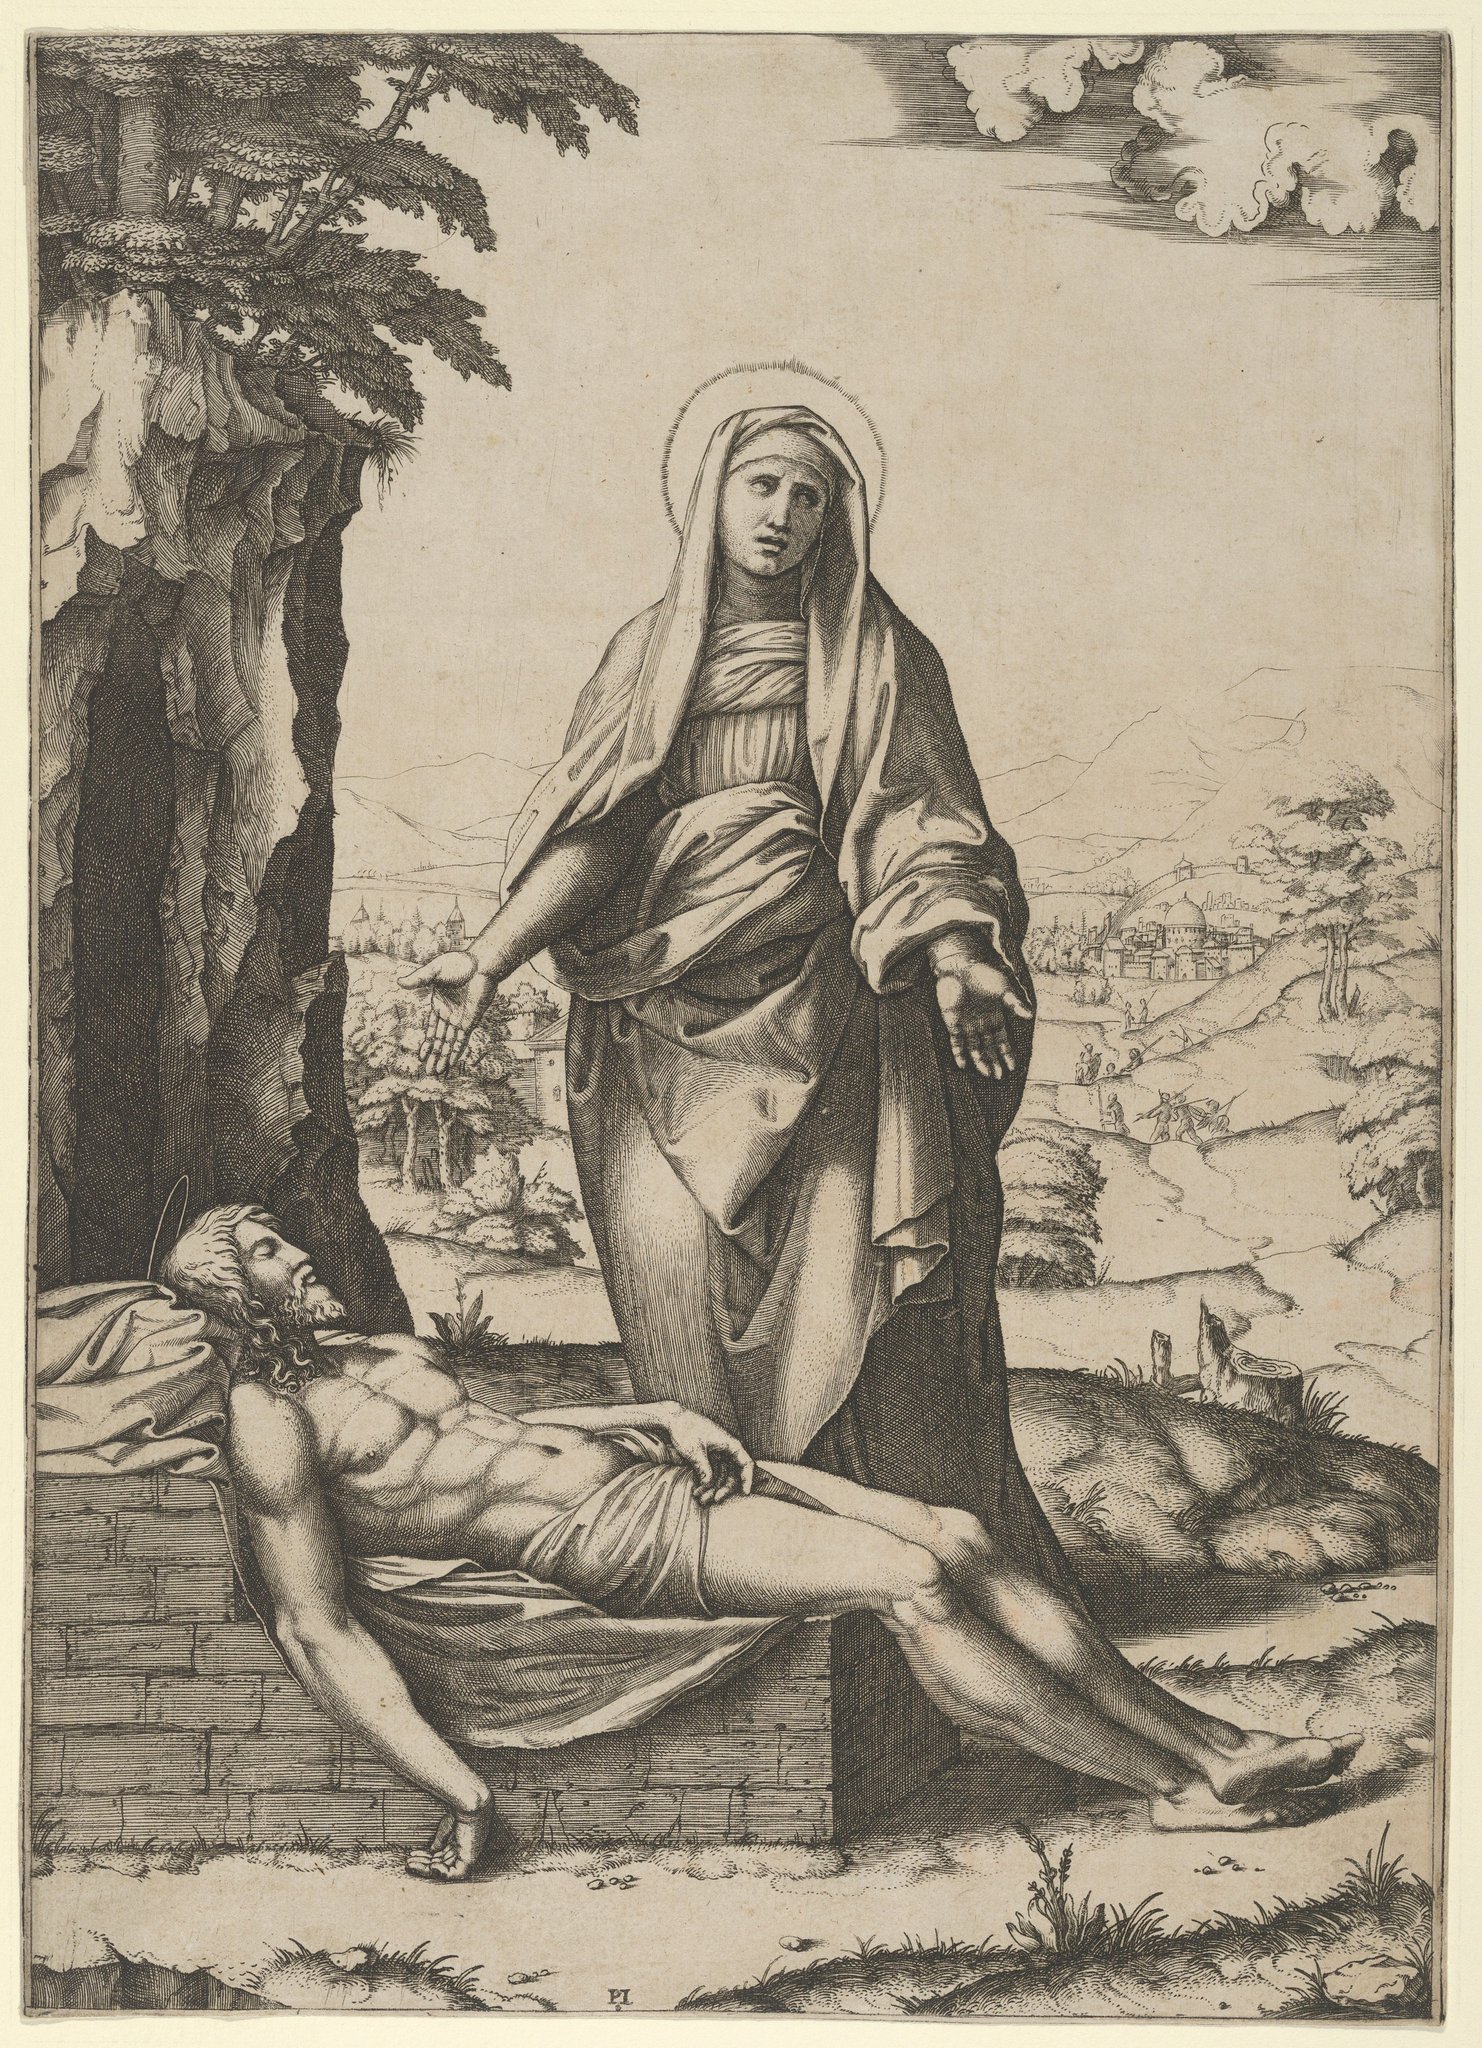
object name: print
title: The Pietà: the Virgin standing over the dead Christ, her hands outspread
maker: marcantonio raimondi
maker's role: artist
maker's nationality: italian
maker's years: 1475-1534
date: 1515-1517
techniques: engraving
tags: christ,virgin mary,death